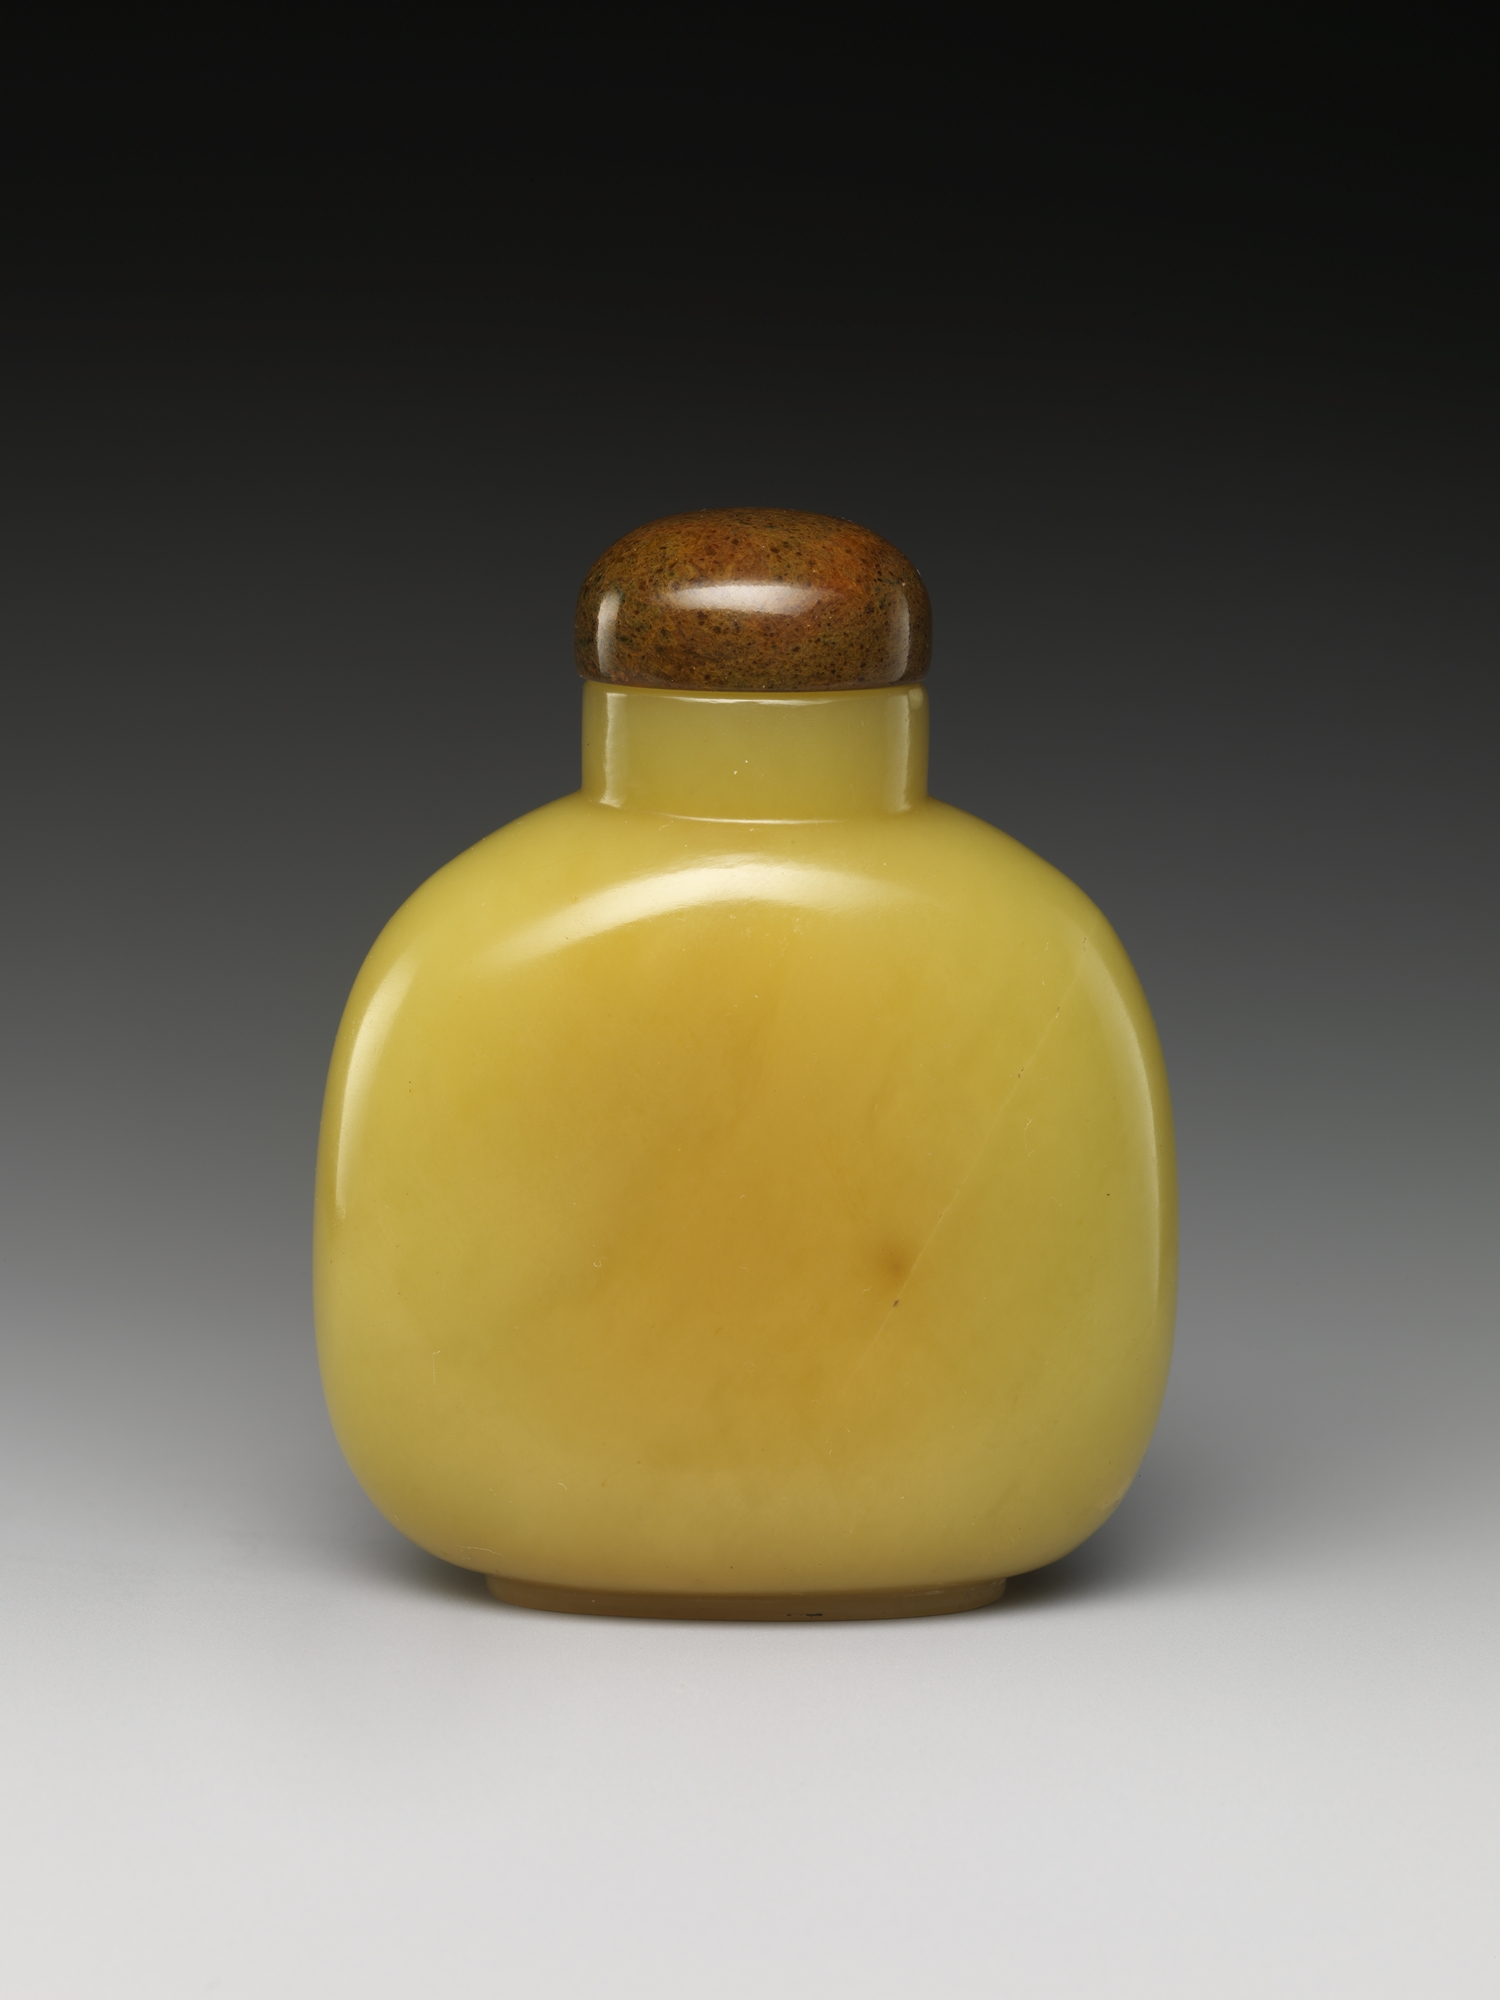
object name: snuff bottle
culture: chinese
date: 1767-1833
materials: stone, jade